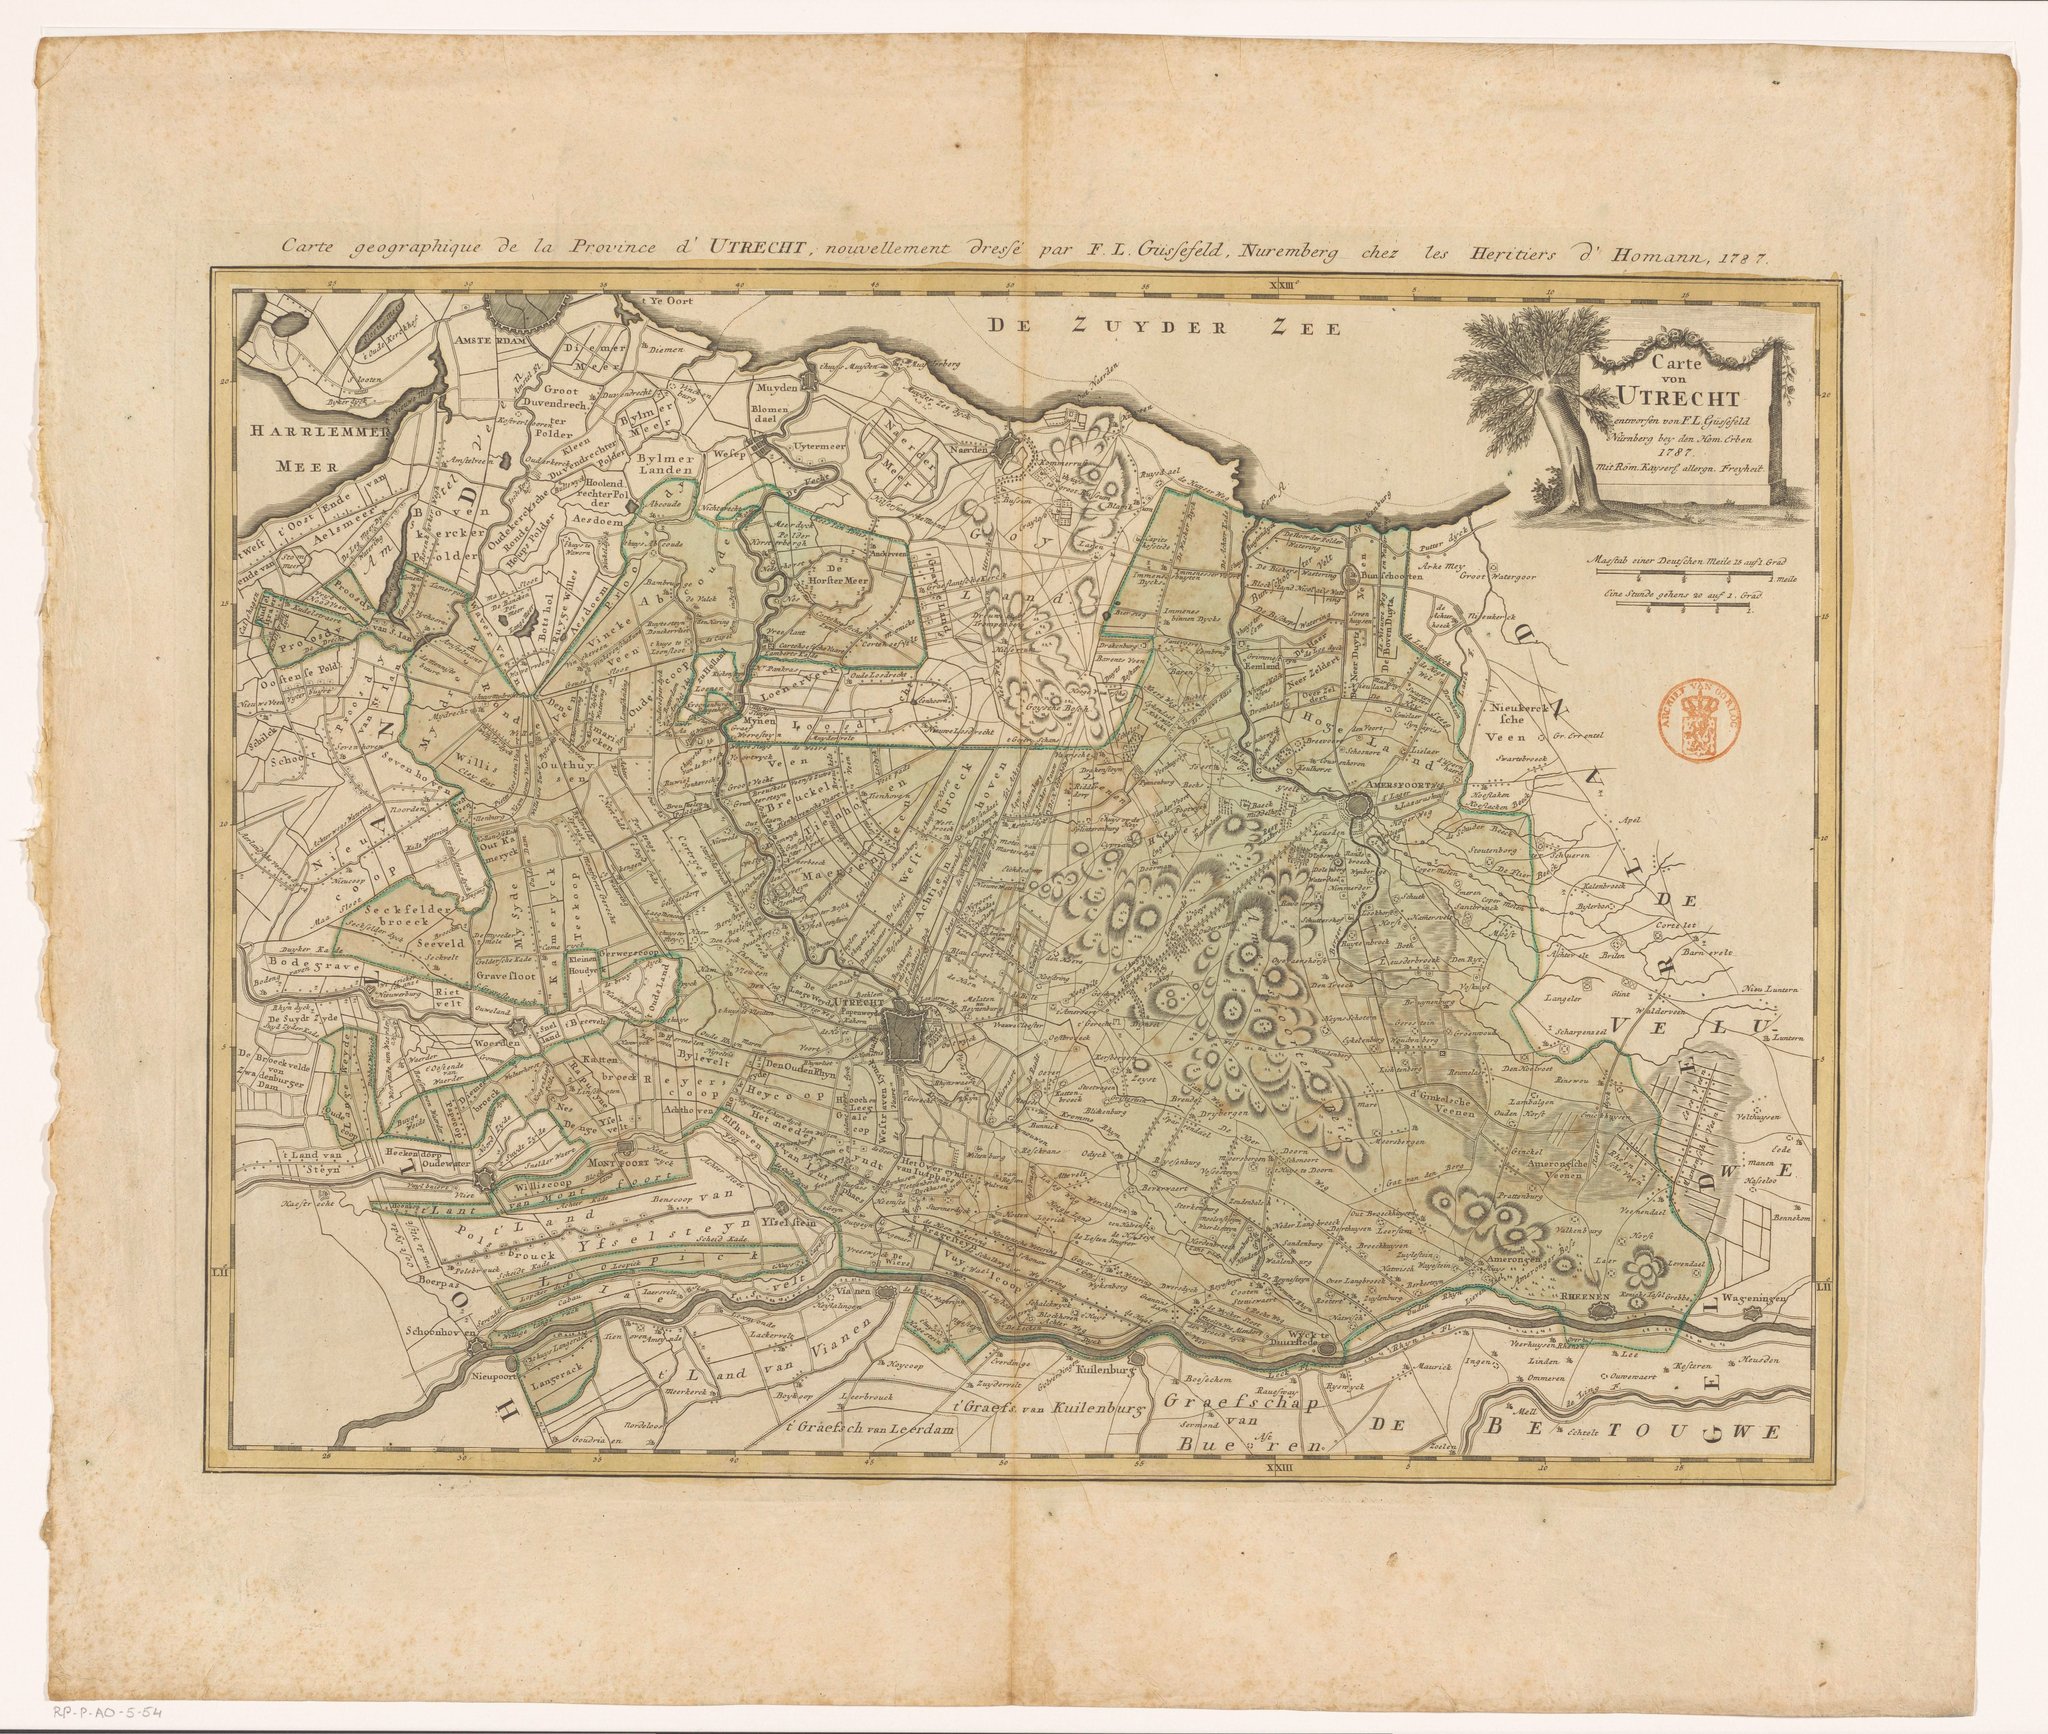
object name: map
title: Carte geographique de la province d'Utrecht … / Carte von Utrecht …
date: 1787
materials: paper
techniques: engraving, hand coloring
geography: nuremberg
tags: maps of separate countries or regions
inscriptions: collector's mark: Lugt 19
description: Boven in de marge de Franse titel, rechtsboven een cartouche met de Duitse titel. Daaronder twee schaalstokken: Masstab einer Deutschen Meile 15 auf 1 Grad; Eine Stunde gehens 20 auf 1 Grad. Gradenverdeling langs de randen.